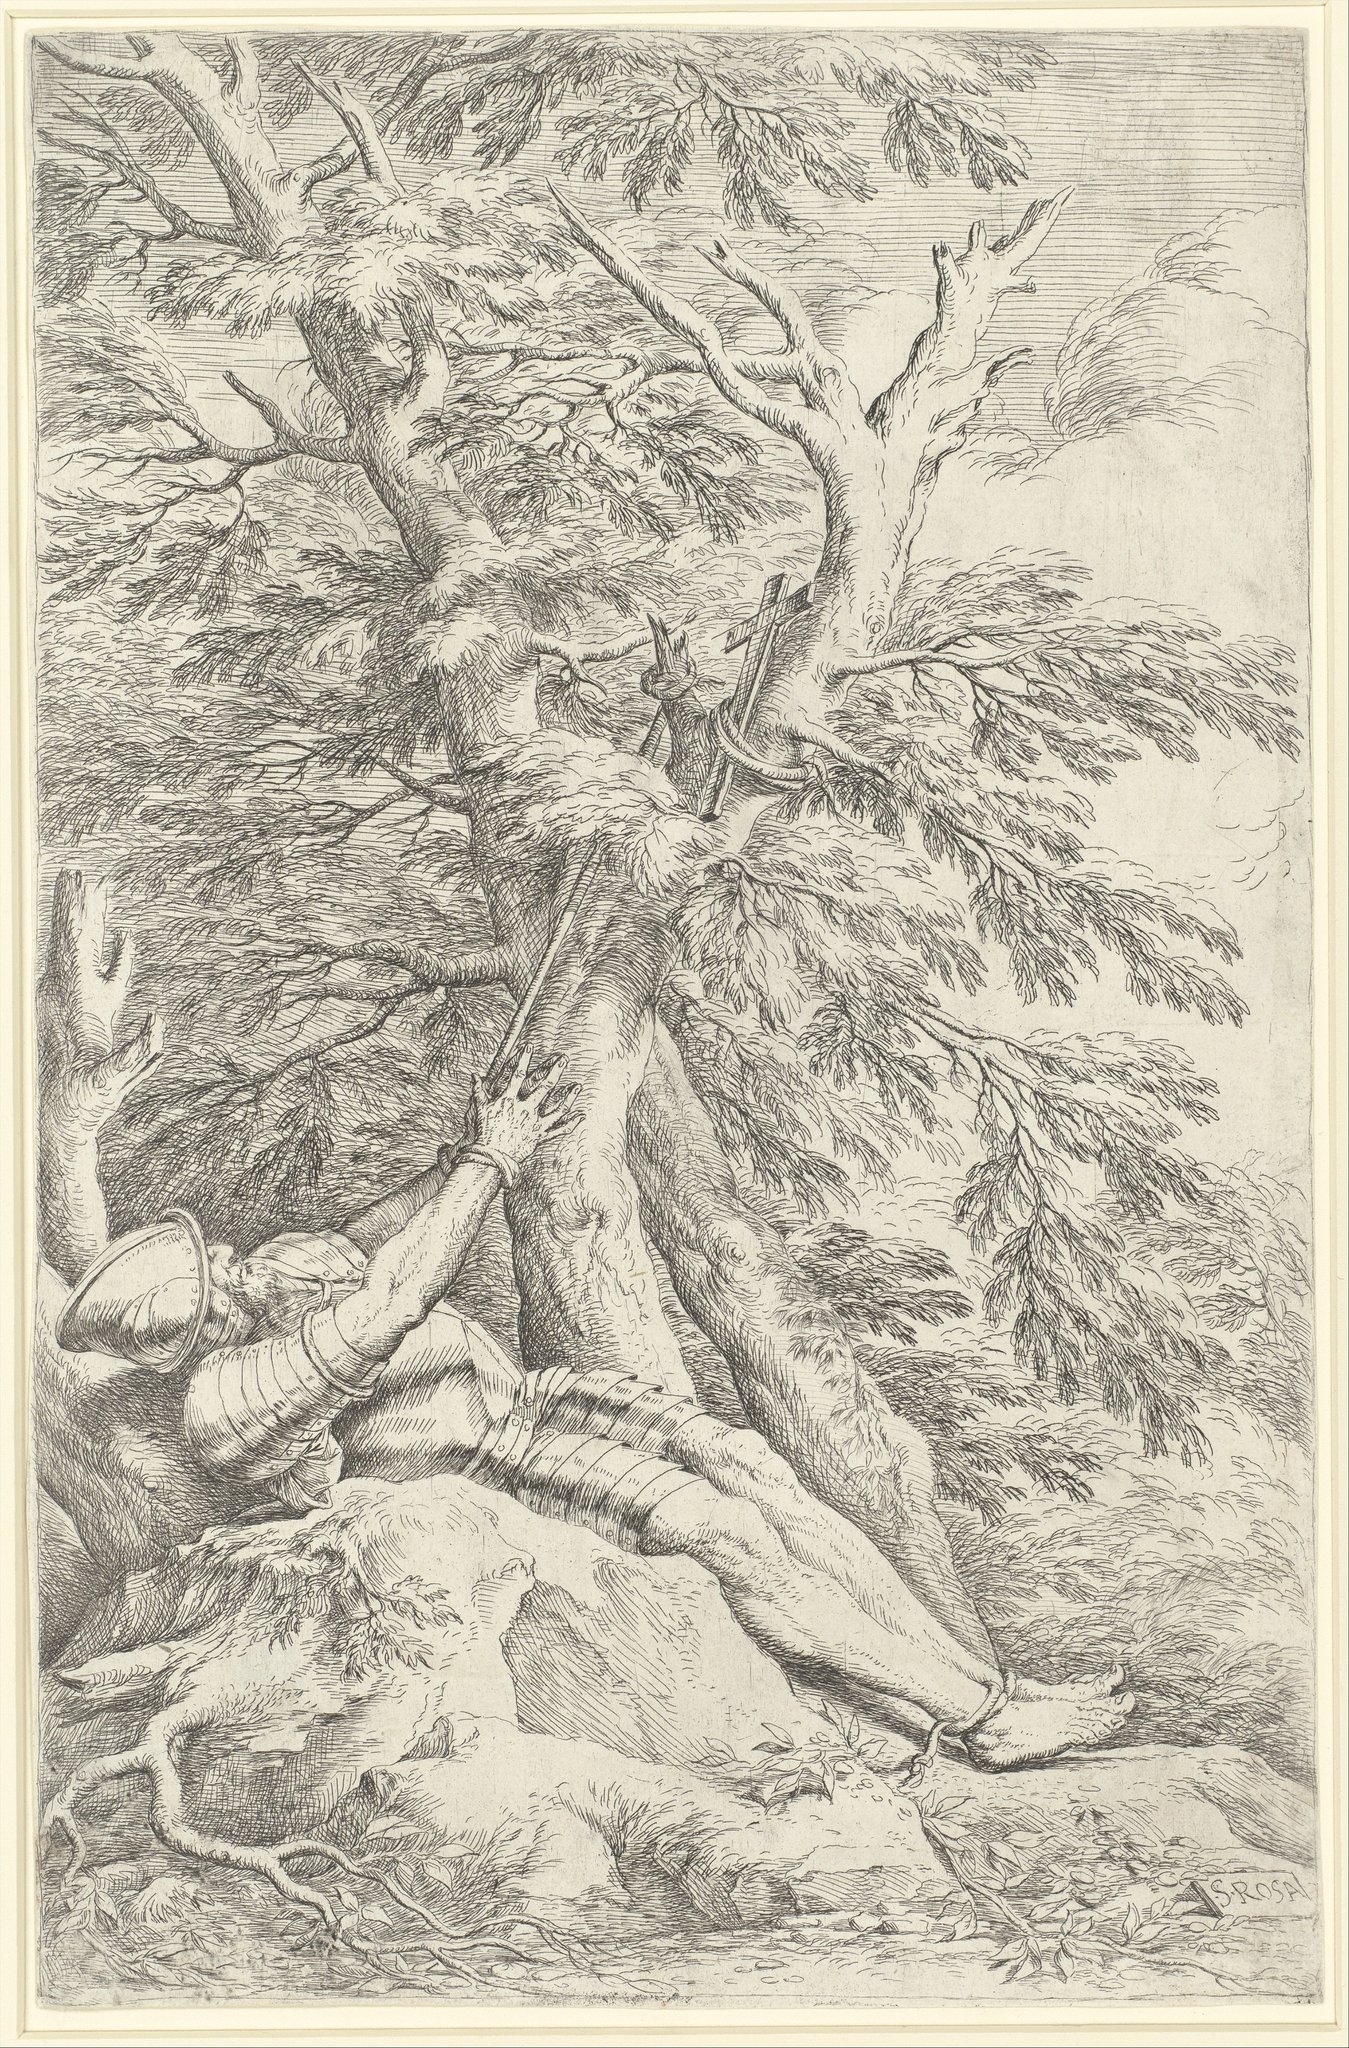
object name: print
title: Saint William of Maleval, hands tied with rope fastened to a tree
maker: salvator rosa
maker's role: artist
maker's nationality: italian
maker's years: 1615-1673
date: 1661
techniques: drypoint, etching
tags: men,trees,saints